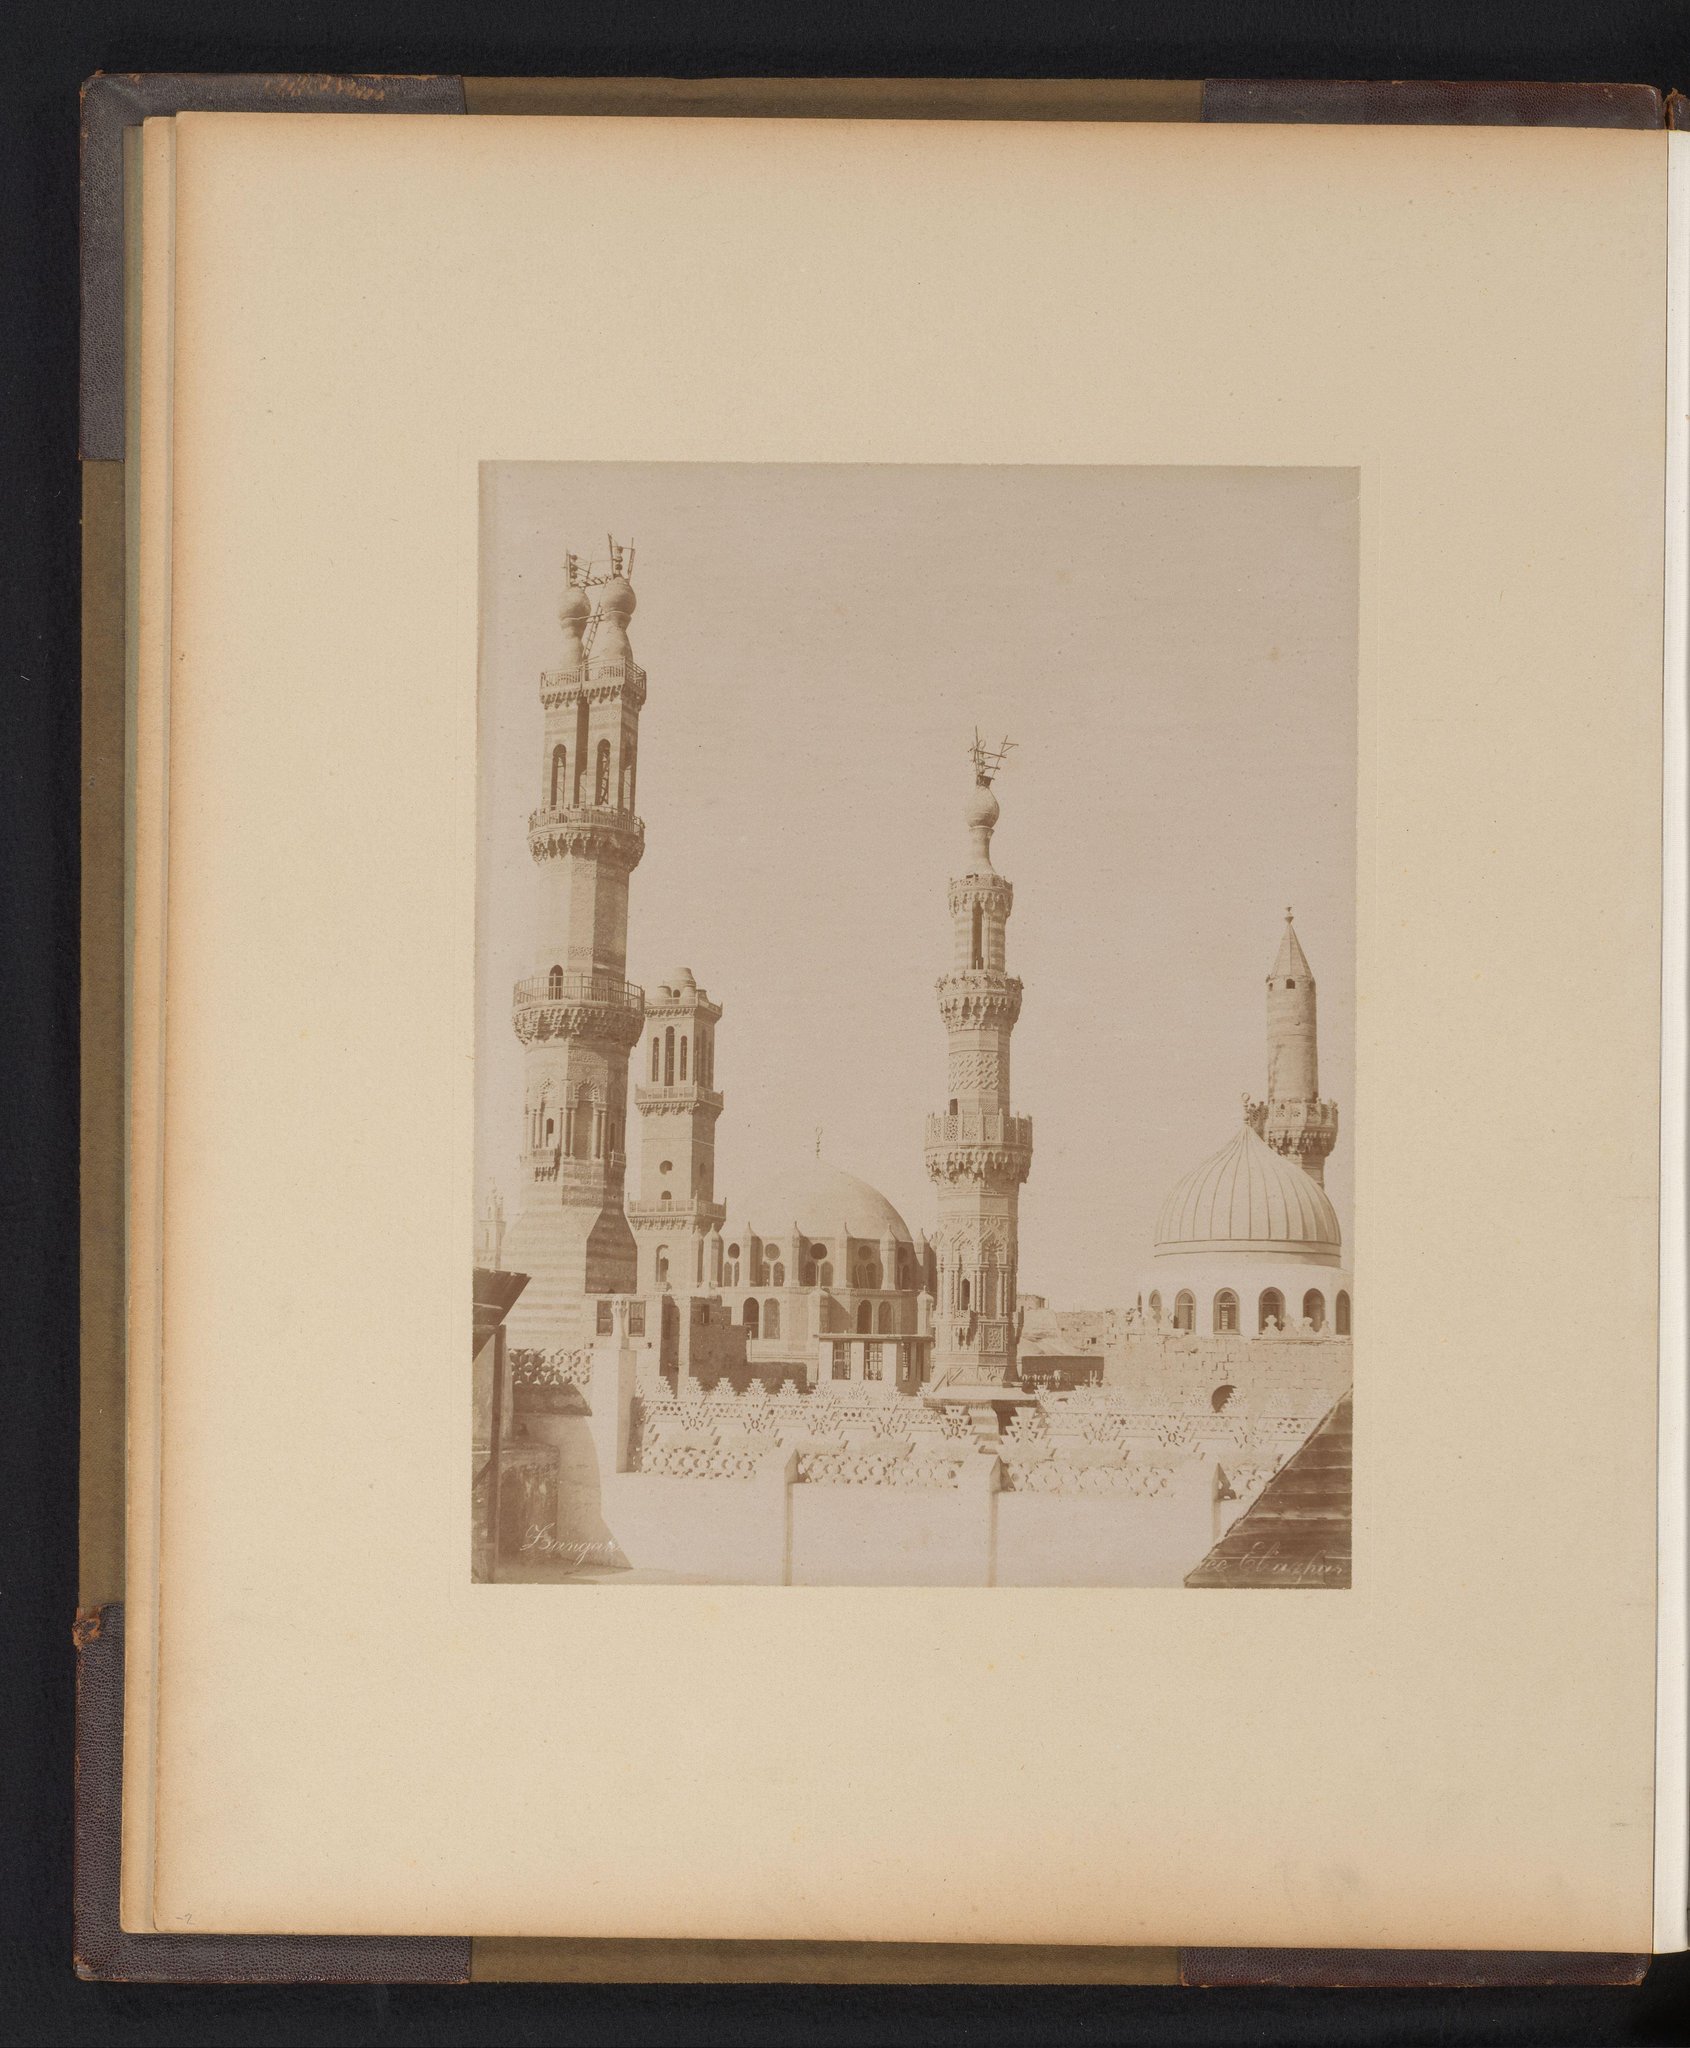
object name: photograph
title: Mosquee Elazhar [?]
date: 1870-1910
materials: paper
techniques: albumen print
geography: cairo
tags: temple, shrine ~ islam, mohammedanism